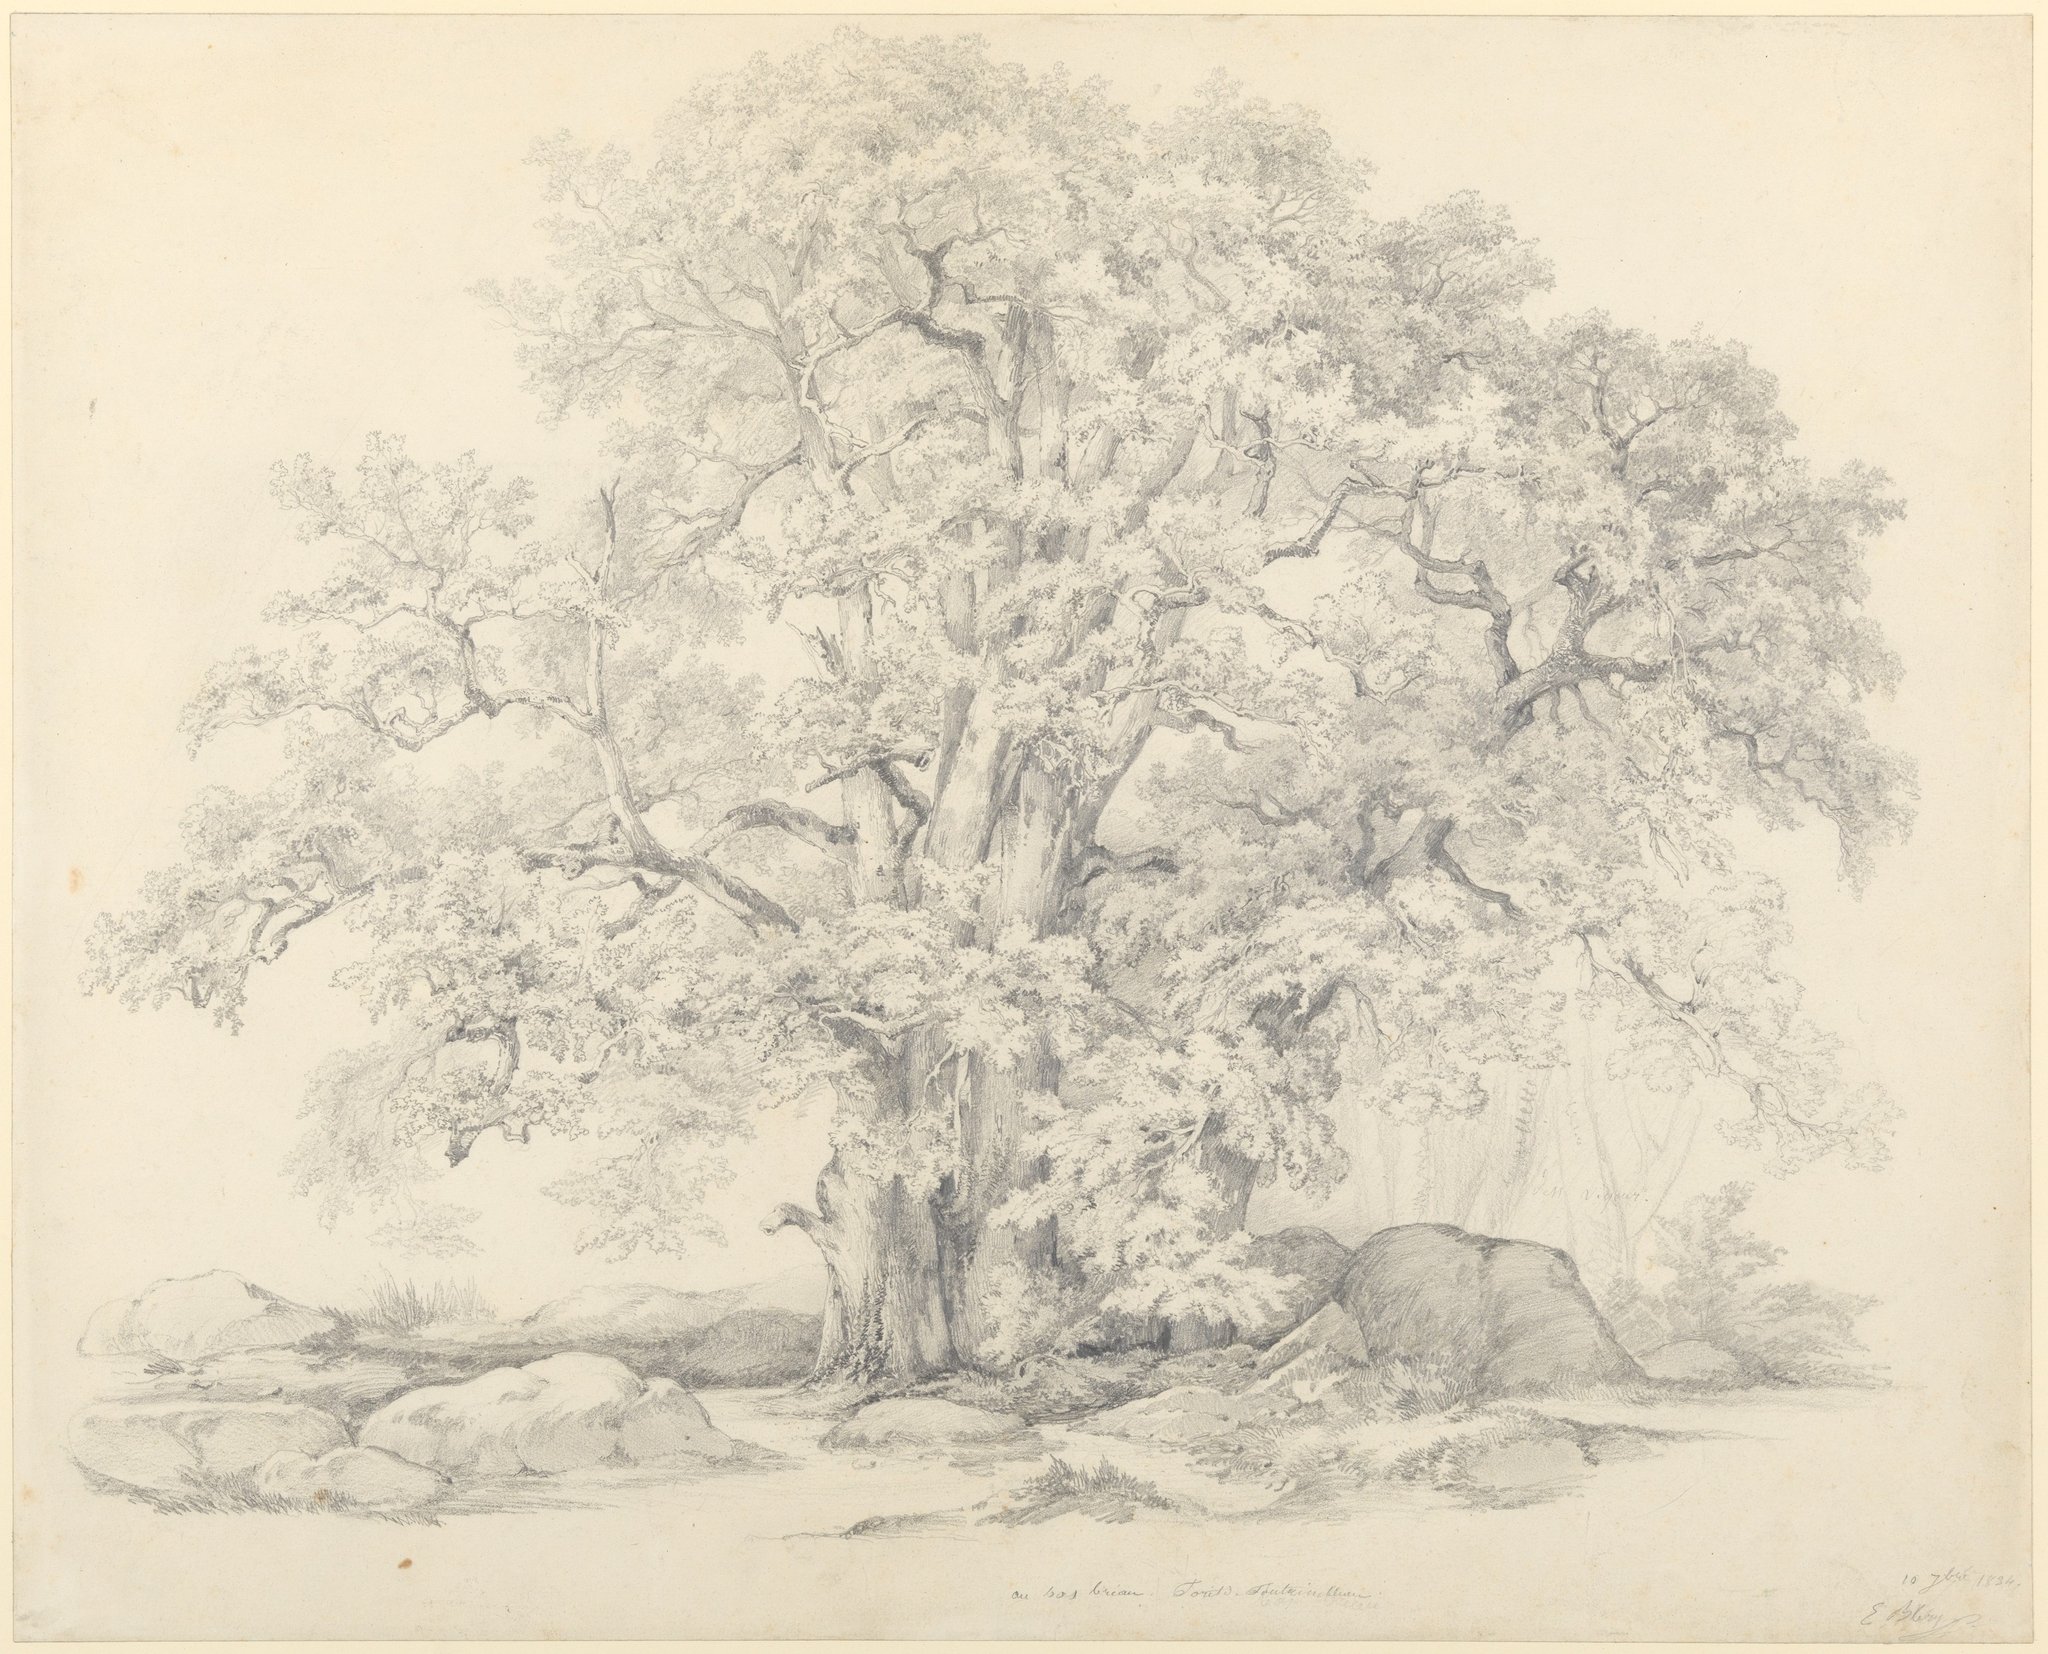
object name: drawing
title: Tree and Rocks in the Forest of Fontainebleau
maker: eugène bléry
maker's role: artist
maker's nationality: french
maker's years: 1805-1887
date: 1834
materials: graphite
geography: france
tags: forests,trees